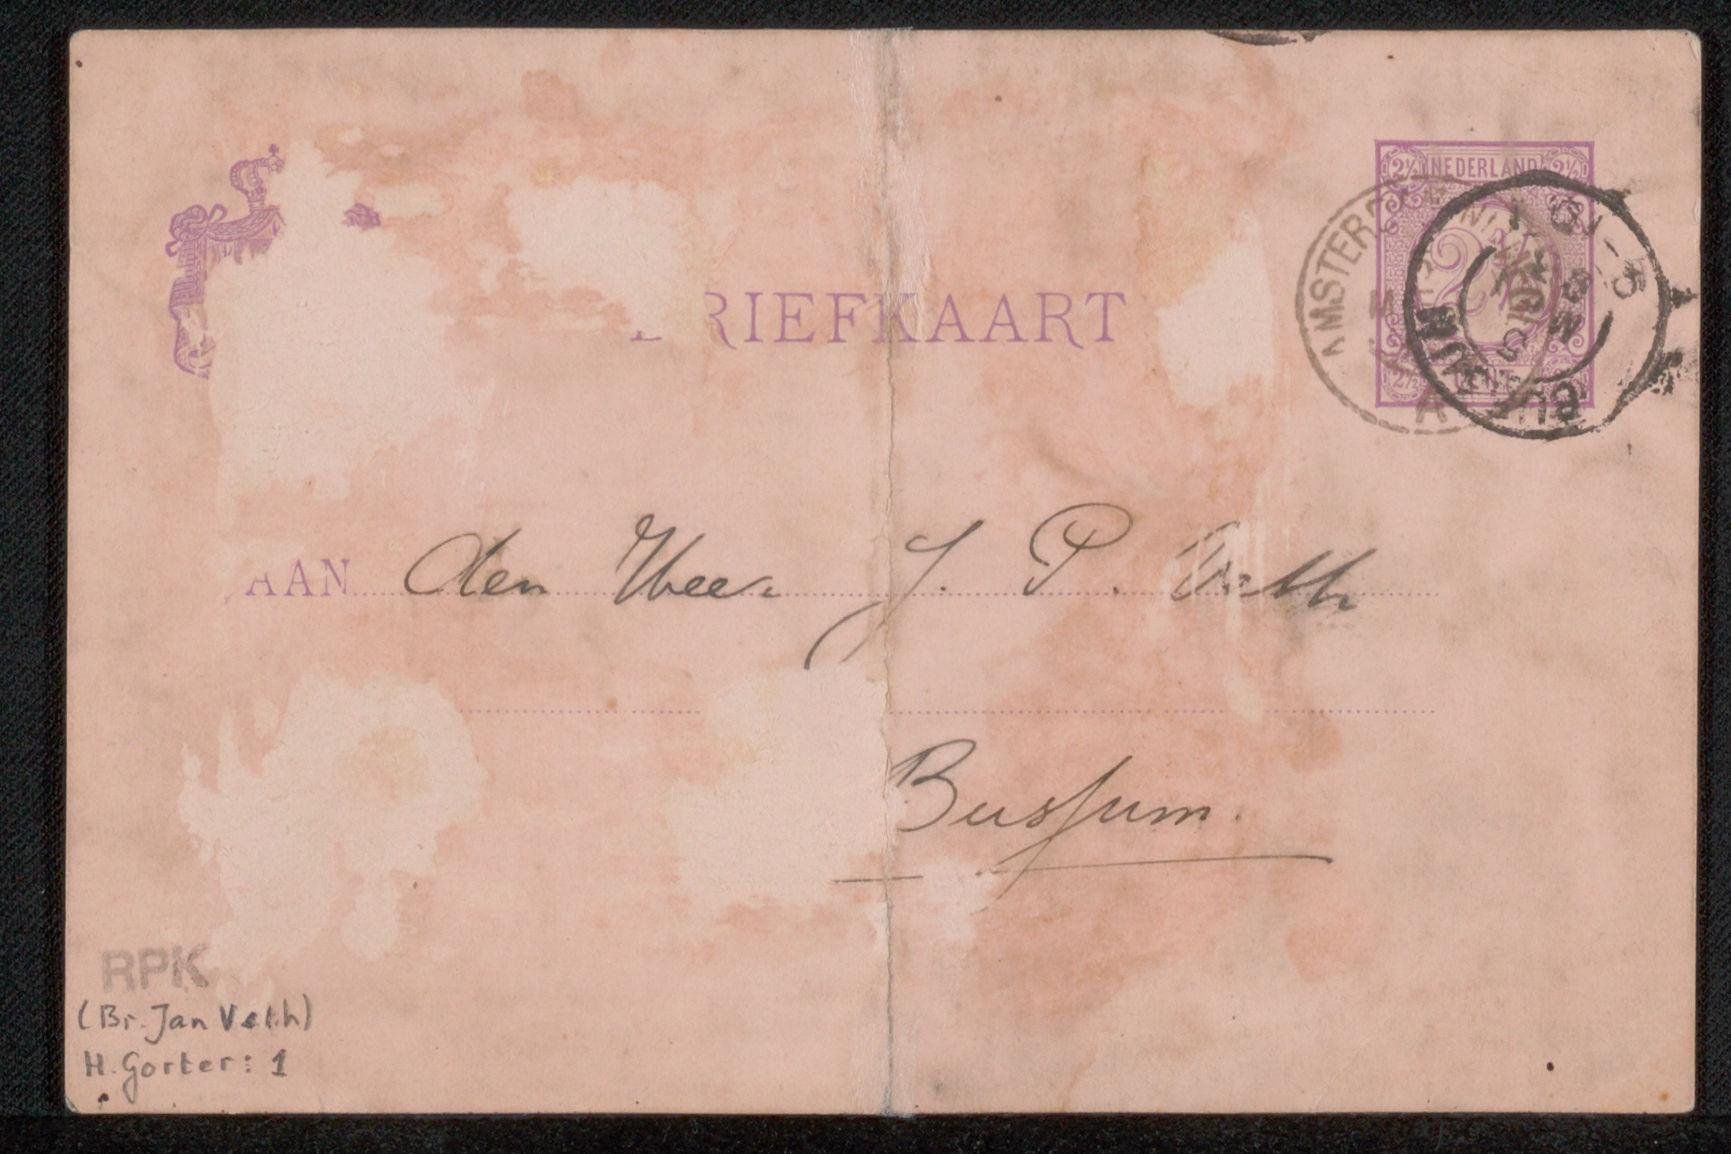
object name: postcard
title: Briefkaart aan Jan Veth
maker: herman gorter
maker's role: letterkundige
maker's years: 1864-1927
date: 1893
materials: cardboard, ink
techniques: pen, writing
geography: amersfoort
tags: dordrecht, painter, print maker, draughtsman, designer, jan veth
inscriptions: collector's mark: ‘RPK’